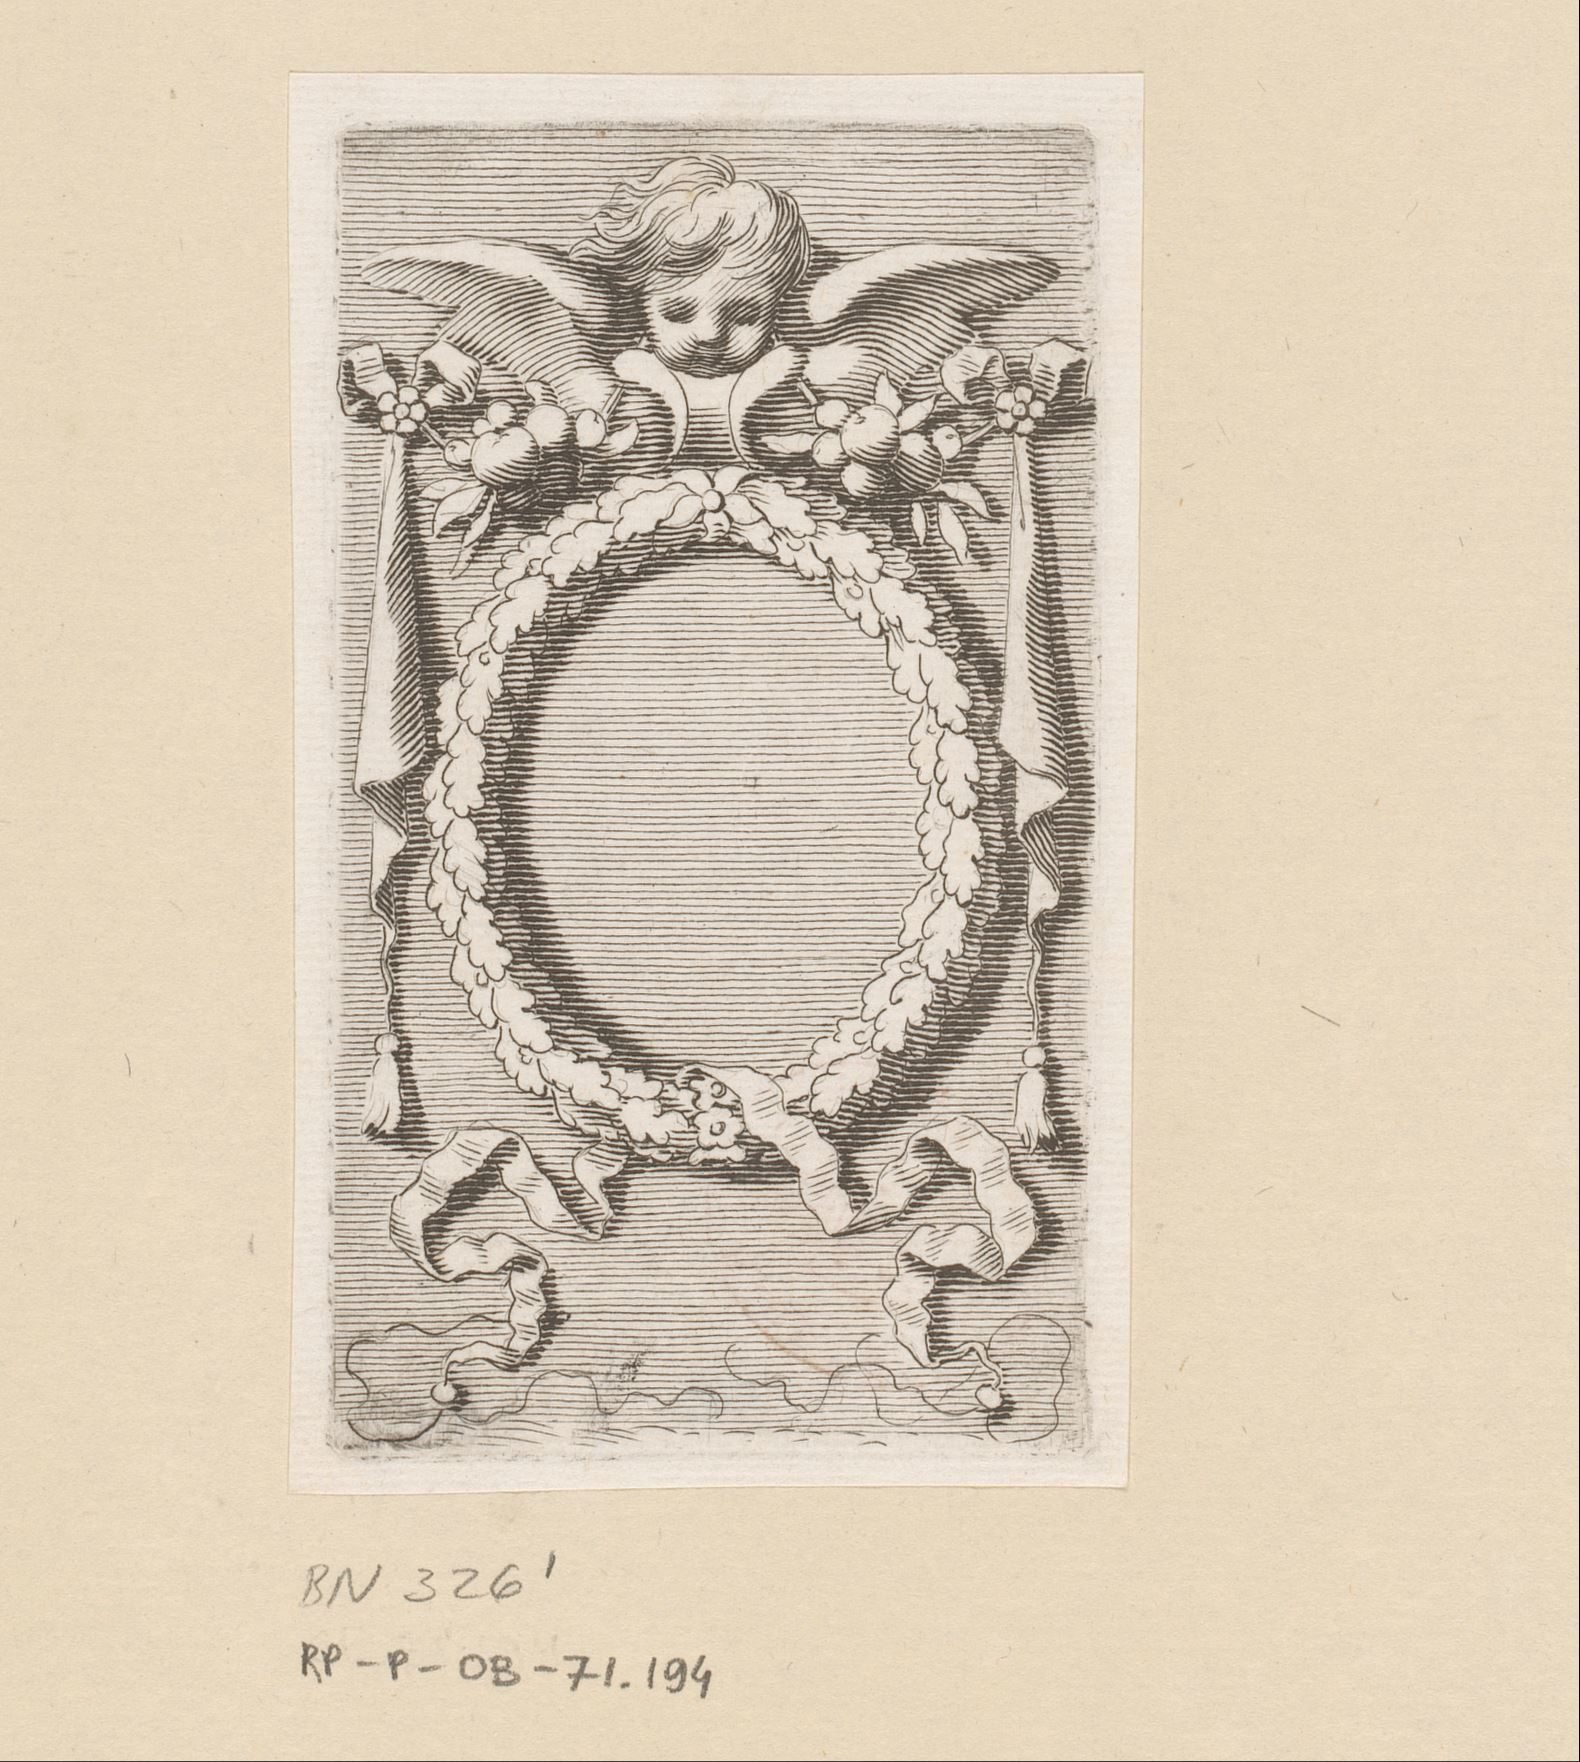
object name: print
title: Titelpagina voor: Jean Desmarets de Saint-Sorlin, L'Office de la Vierge Marie (...), 1645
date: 1645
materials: paper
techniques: engraving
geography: paris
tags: cherubs, i.e. children's heads with wings, ornament ~ cartouche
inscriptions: collector's mark: Lugt 240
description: Titelpagina voor: Desmarets de Saint-Sorlin, Jean. L'Office de la Vierge Marie (...). Parijs: Henri Le Gras, 1645.